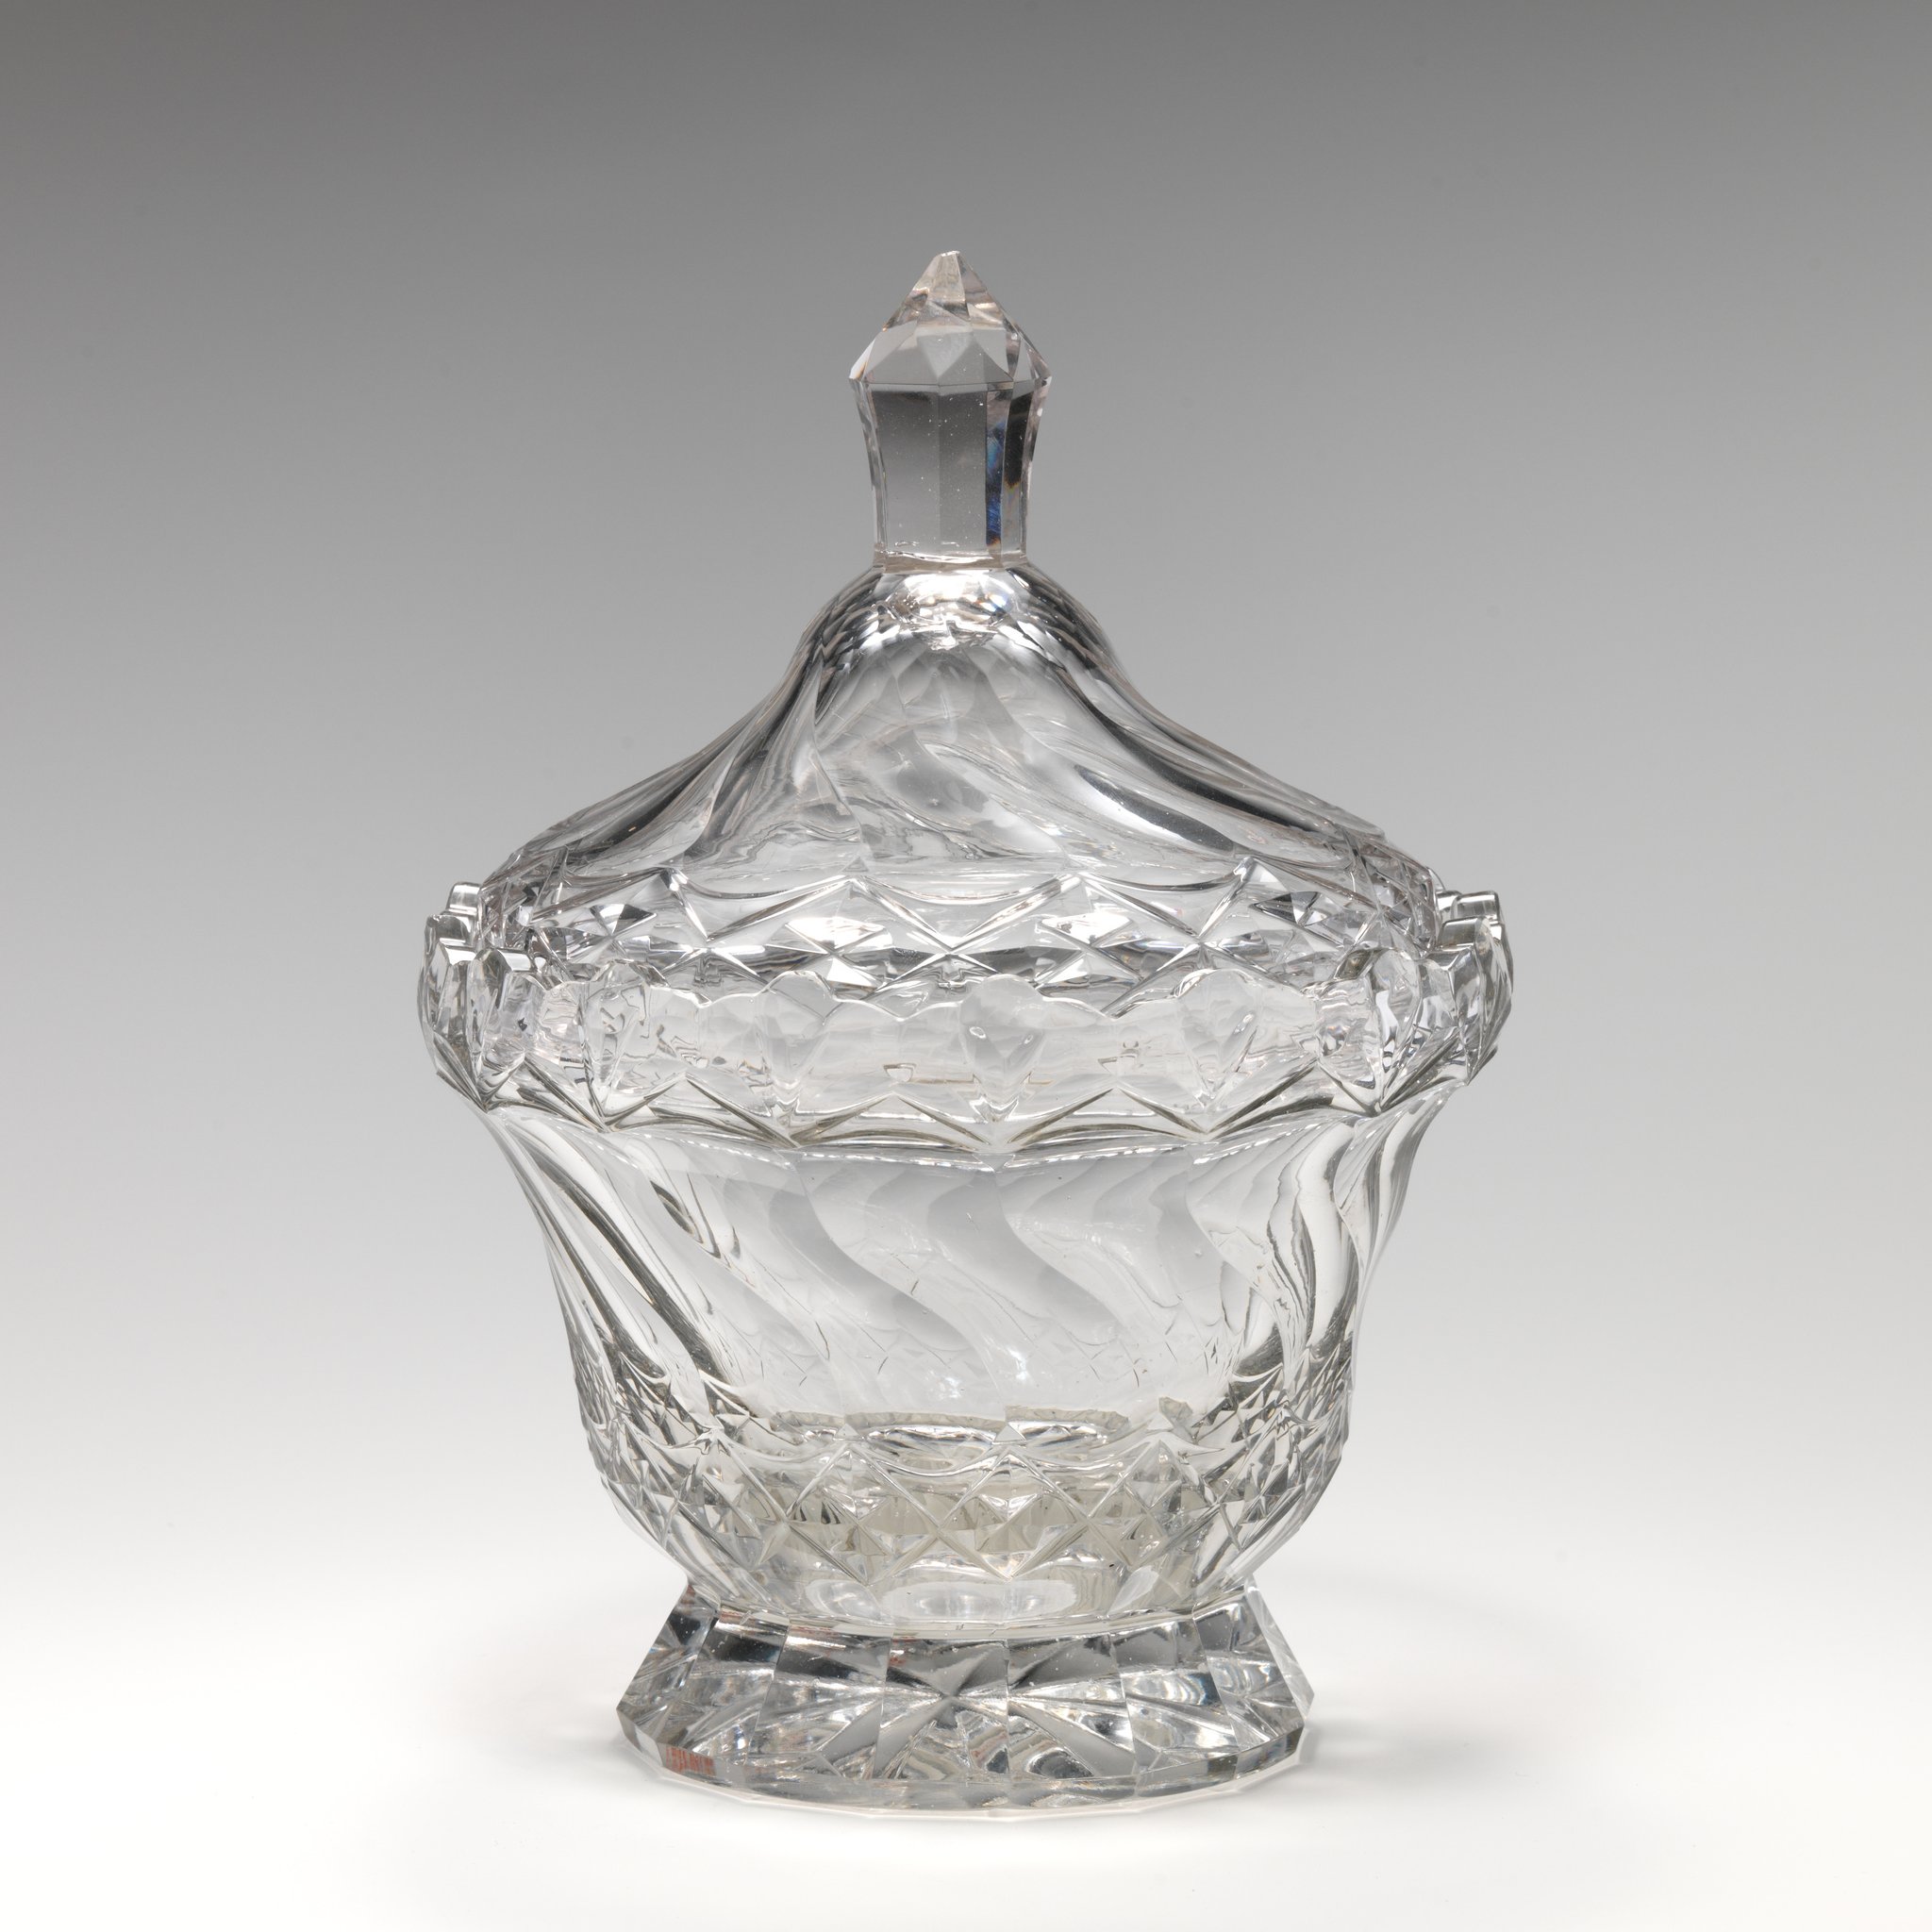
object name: bowl with cover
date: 1801-1900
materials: glass